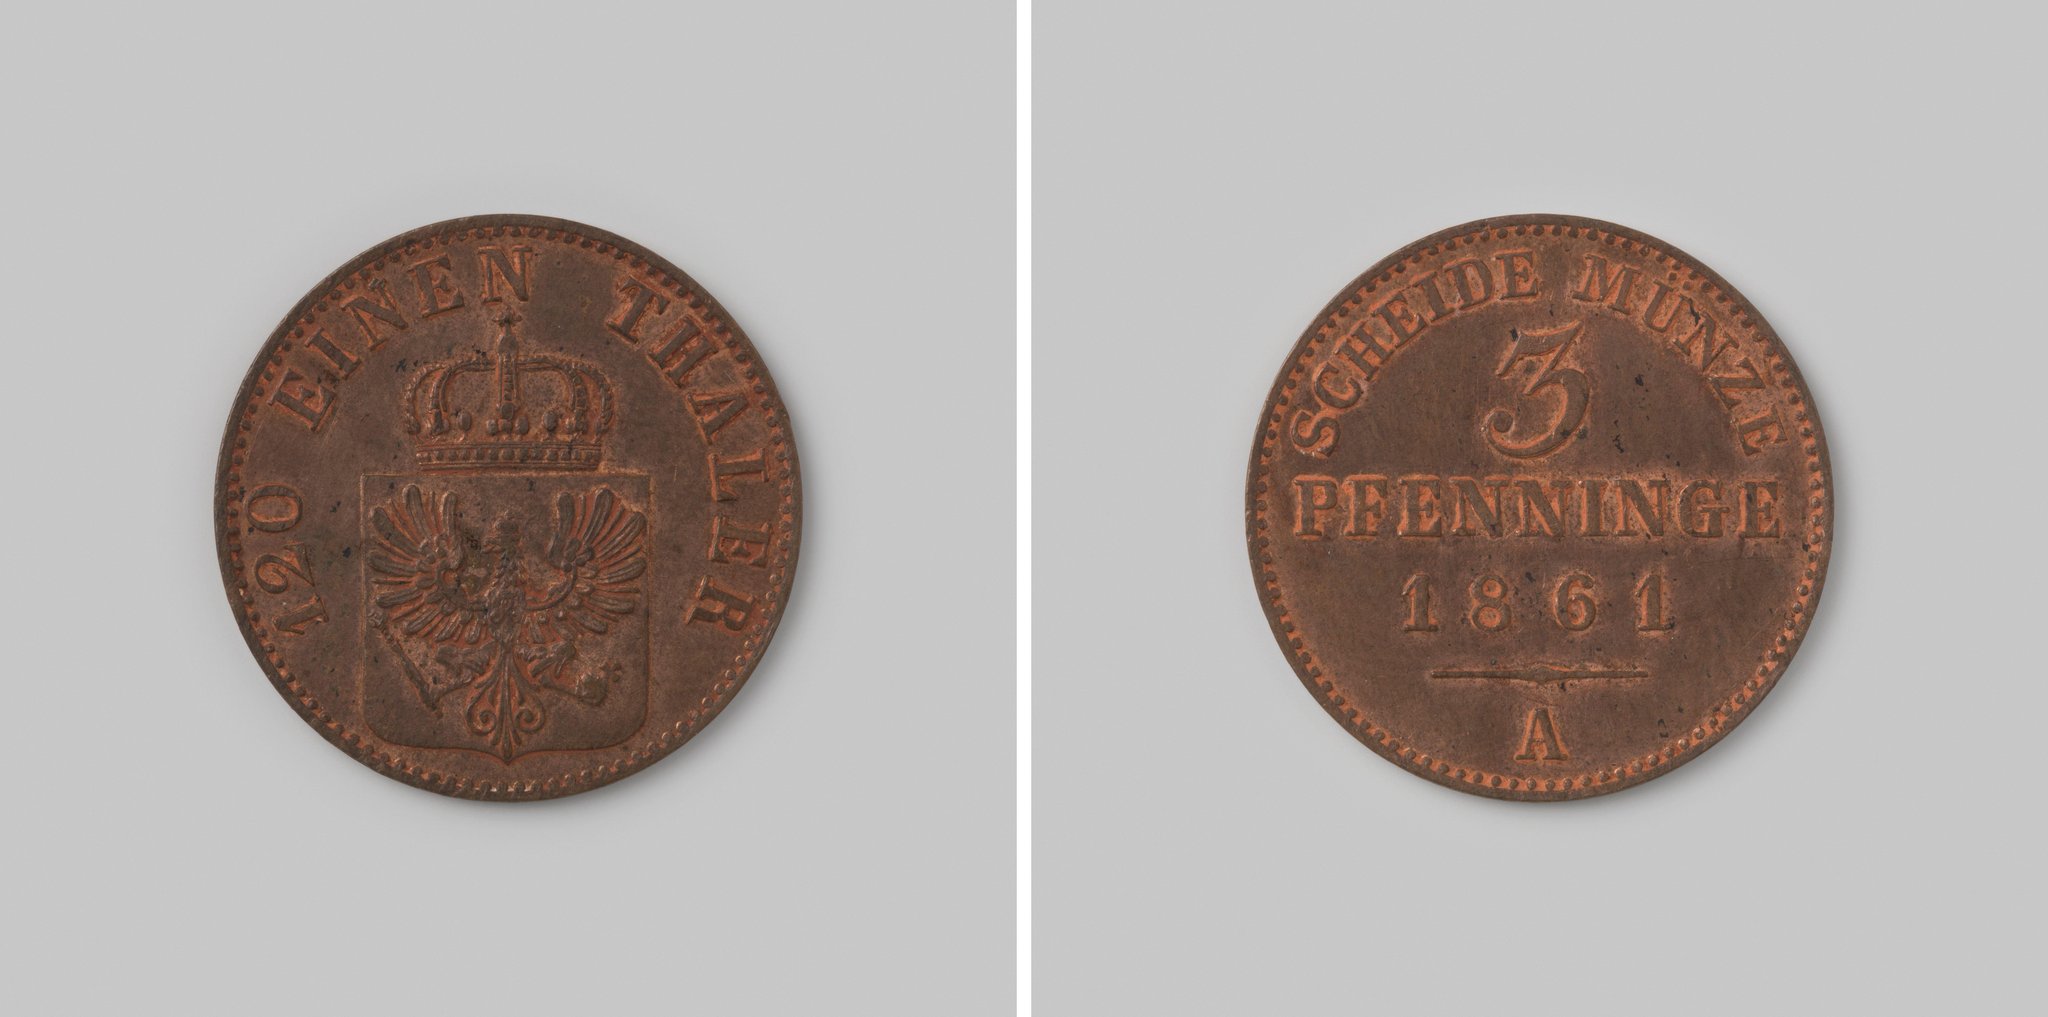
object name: coin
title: 3 Pfenninge uit Pruisen van Wilhelm I, 1861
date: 1861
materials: copper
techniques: striking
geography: berlin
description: Koperen munt. Voorzijde: gekroond wapenschild. Keerzijde: waarde-aanduiding in twee regels. Daaronder jaartal. gladde rand.